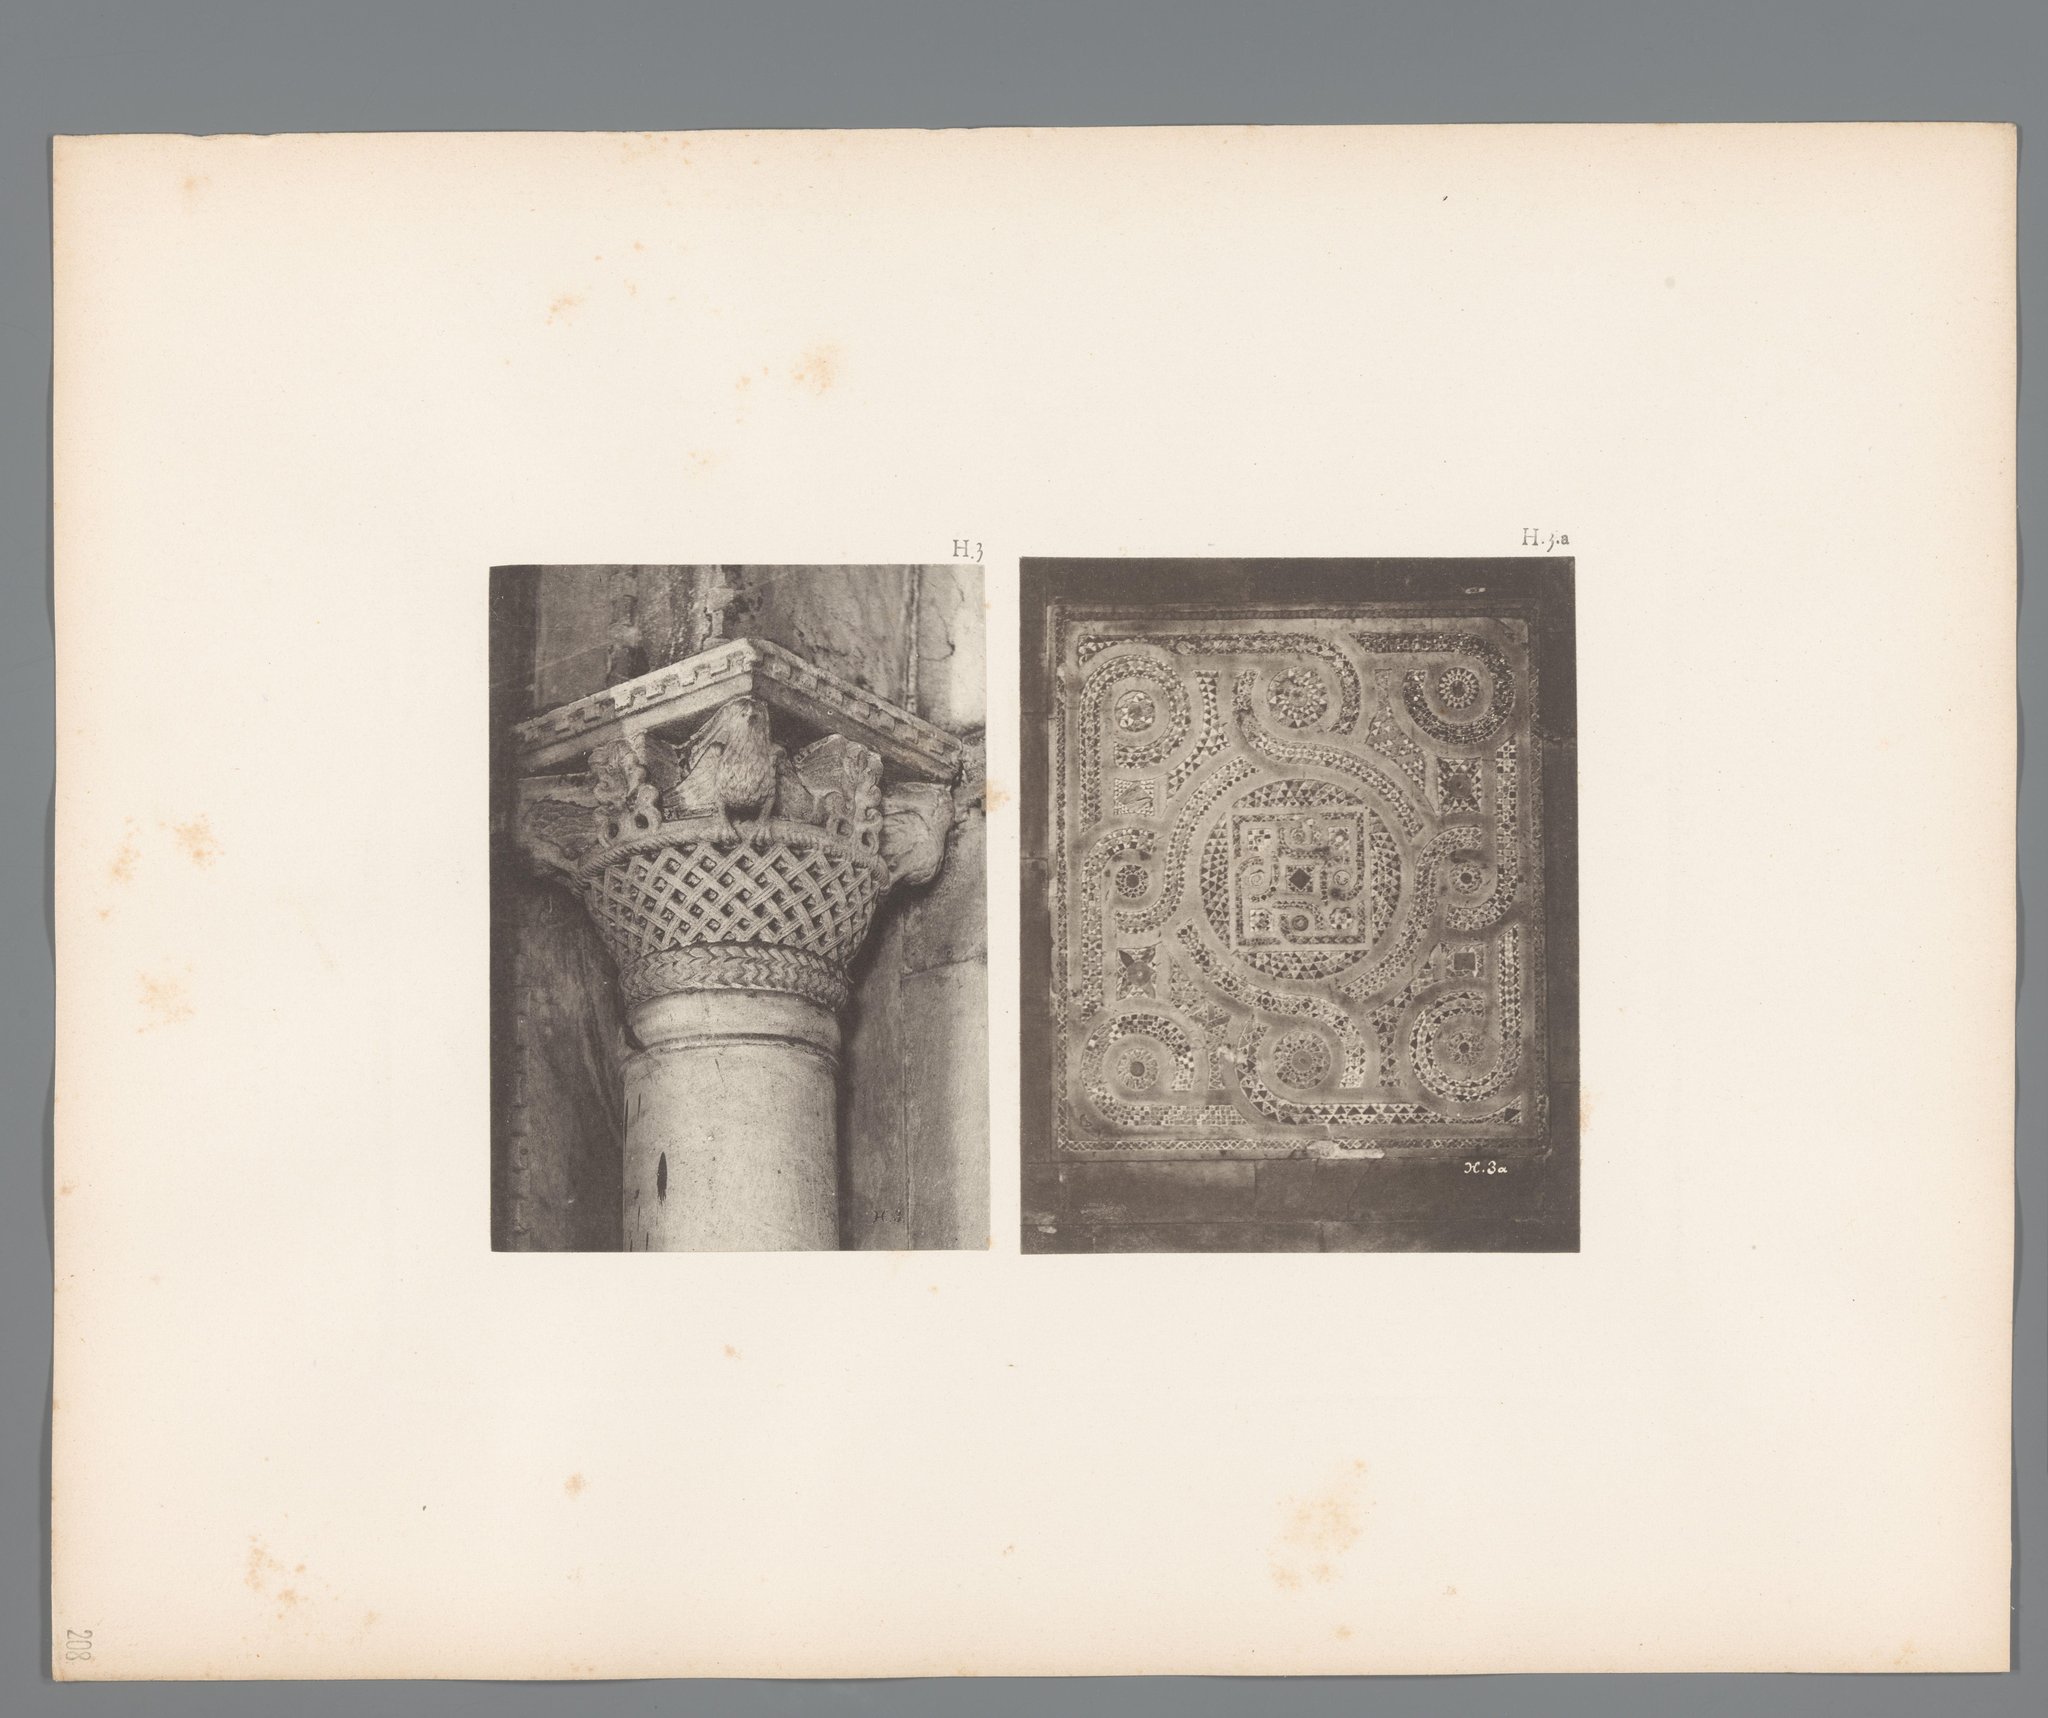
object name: photomechanical print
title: Kapiteel en een mozaïek van de San Marco in Venetië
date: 1880-1885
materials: paper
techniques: photograph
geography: venice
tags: architectural detail, capital (~ column, pillar) (+ styles in art ~ ancient historical period), church (exterior)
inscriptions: number: ‘H.3.’, number: ‘H.3a’, number: ‘H.3.a’, number: ‘208.’, number: ‘H.3’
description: Deze prenten maken deel uit van een omslag met 79 prenten op 53 bladen en 2 tekstbladen.